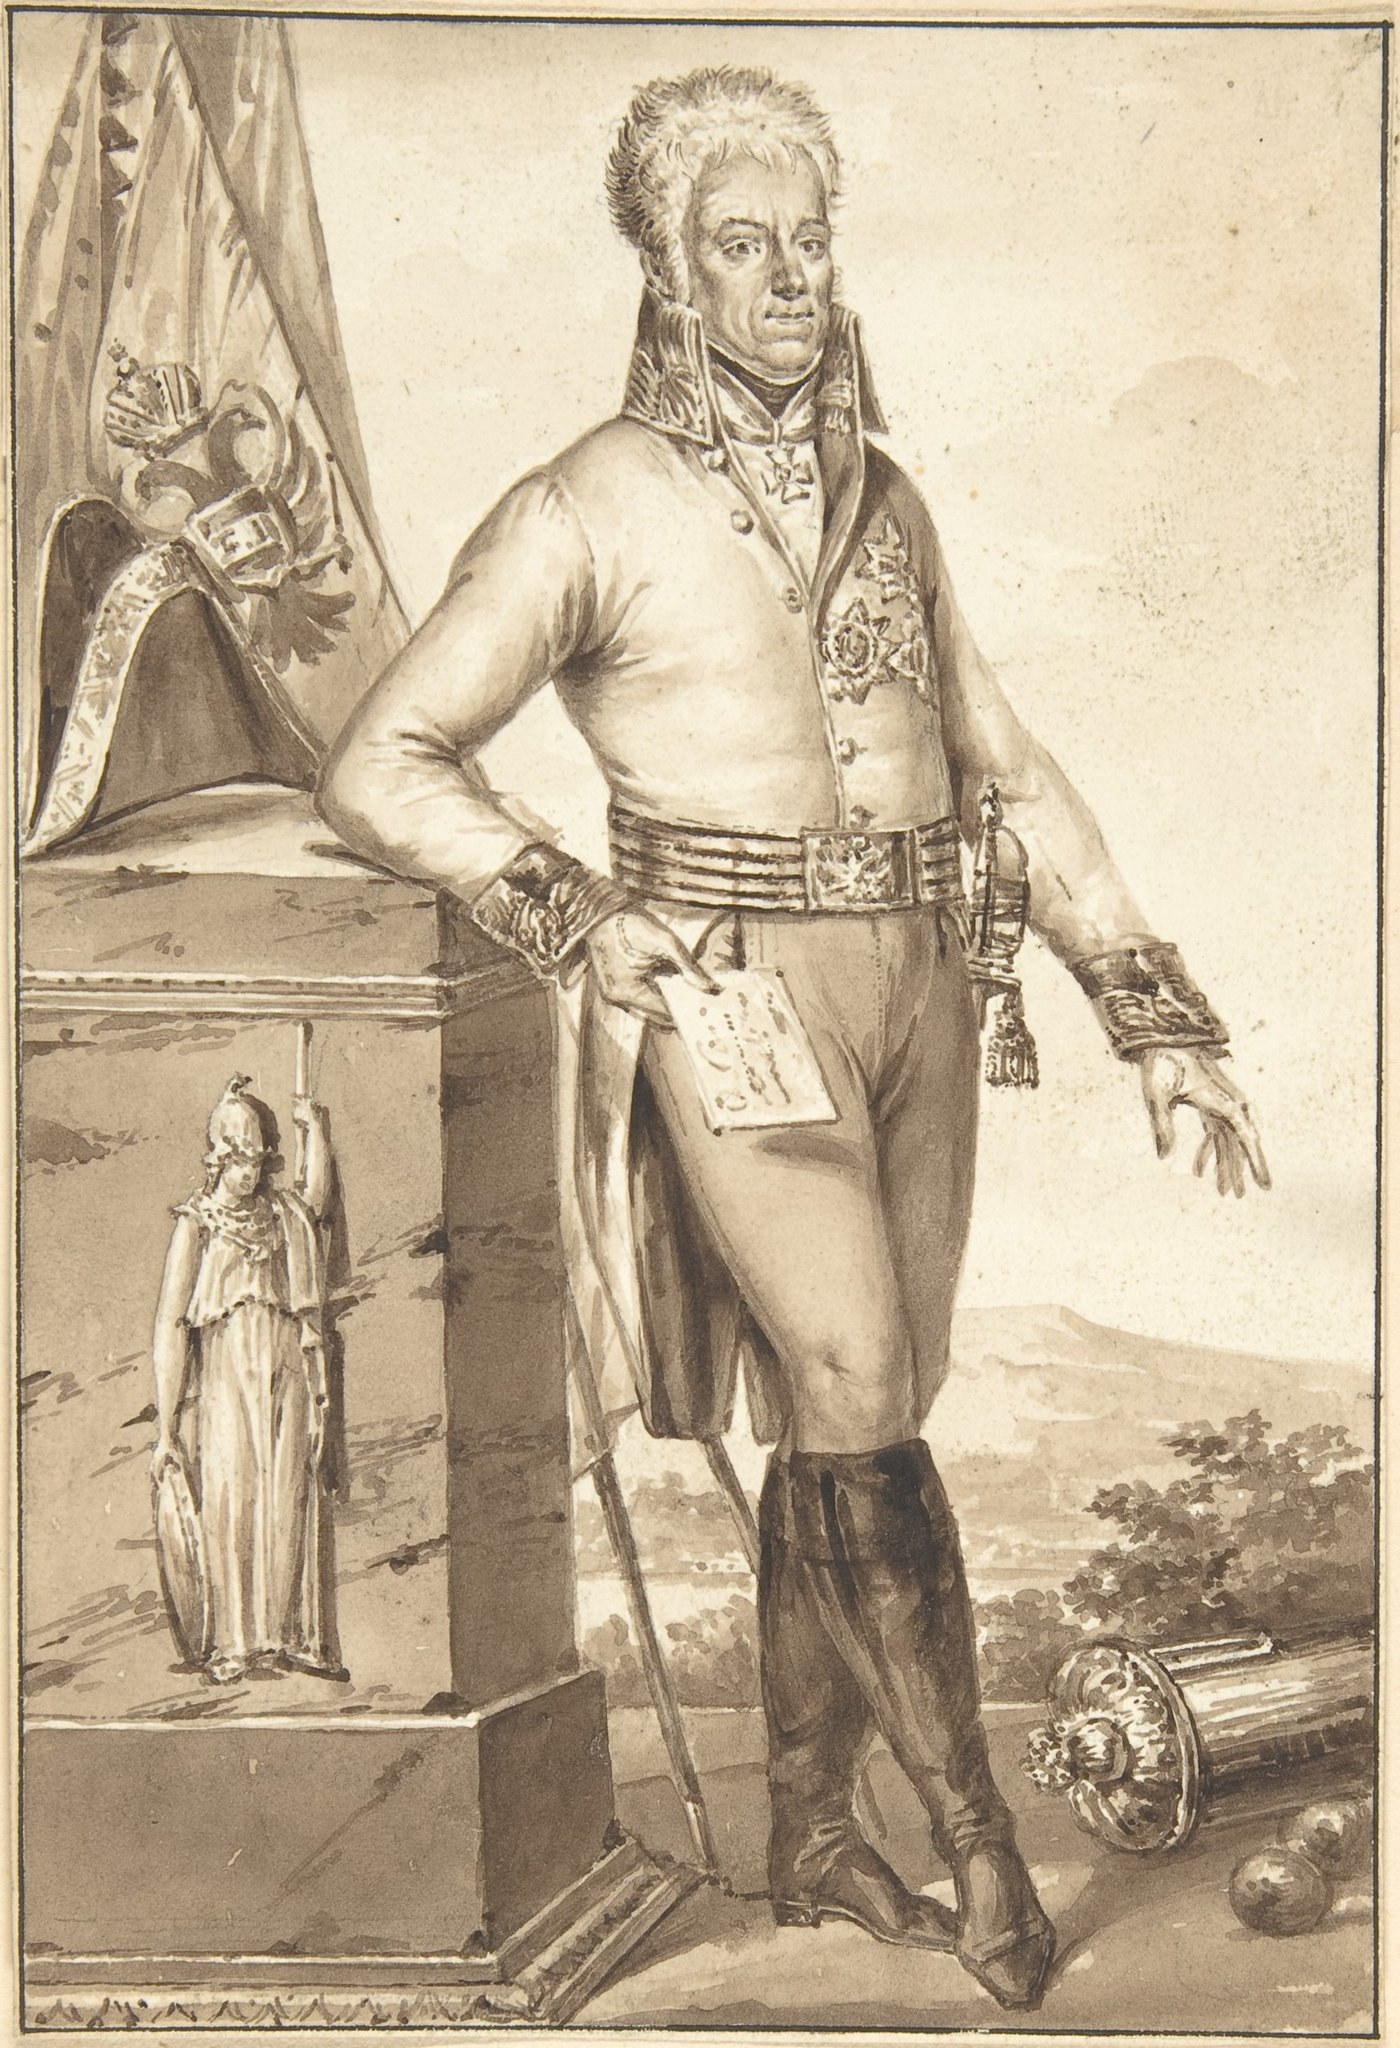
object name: drawing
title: Portrait of Count Heinrich Joseph von Bellegarde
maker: jean-baptiste-françois bosio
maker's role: artist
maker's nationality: french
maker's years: 1764-1827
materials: graphite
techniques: brush, wash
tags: men,portraits